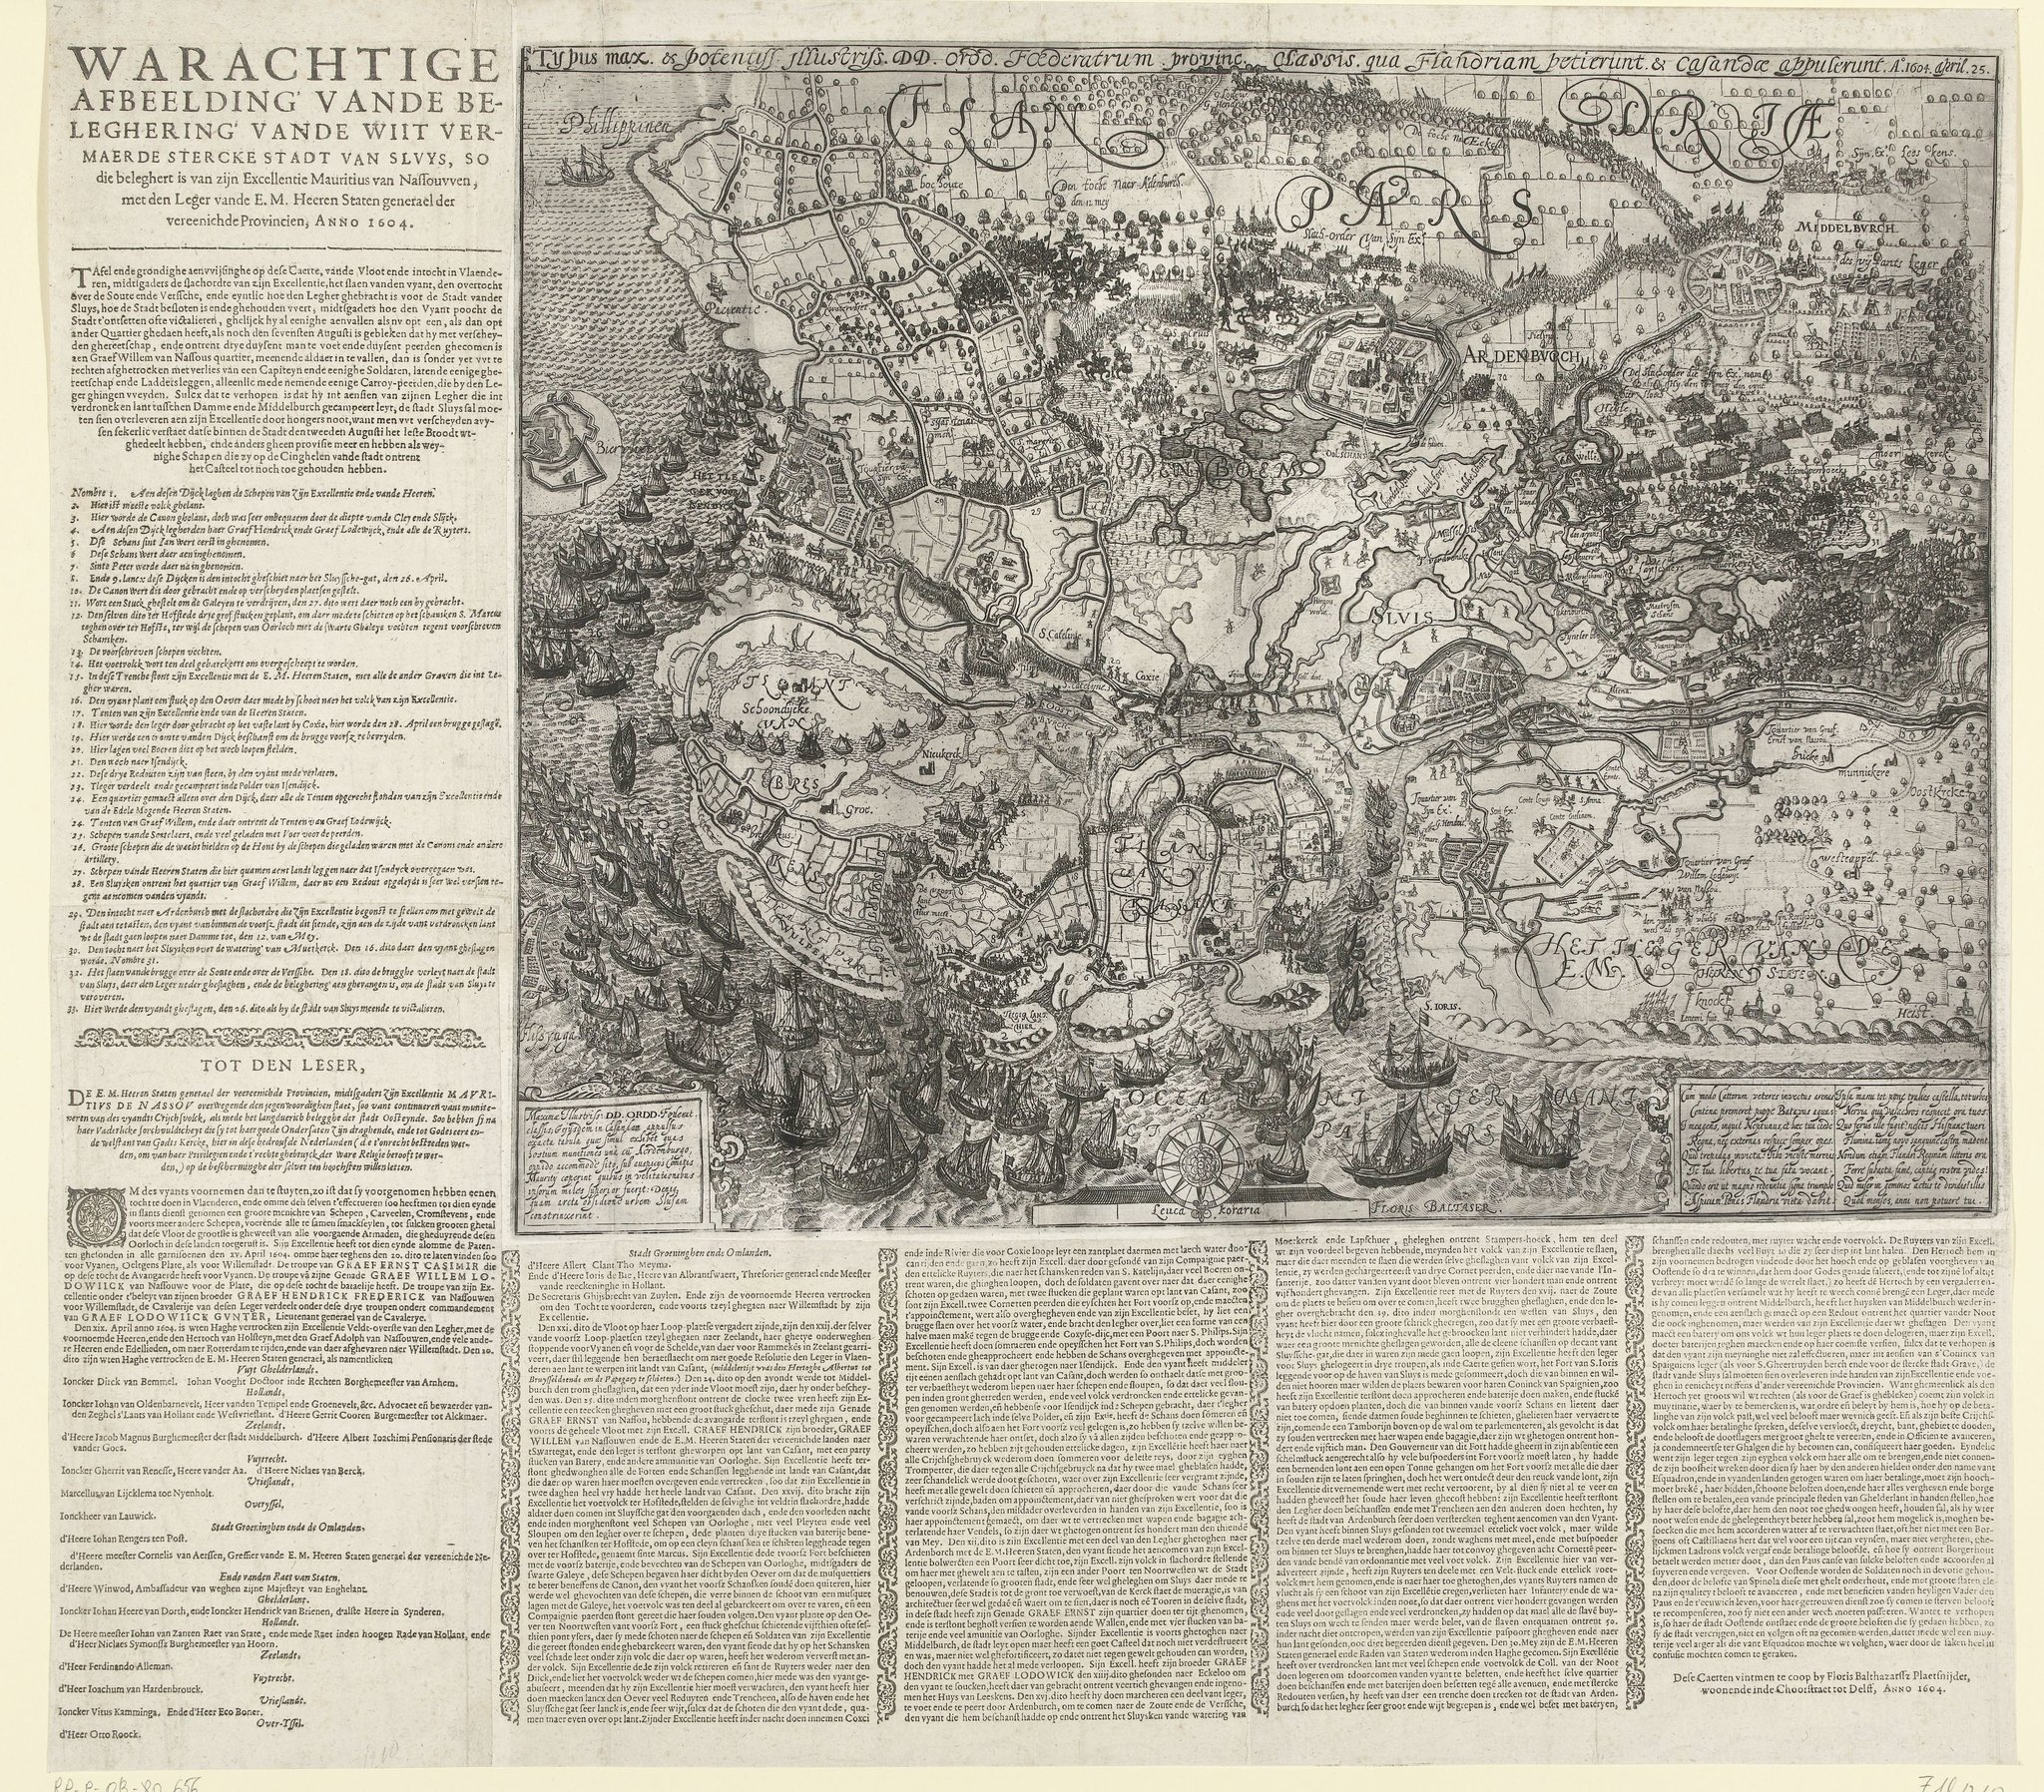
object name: map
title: Warachtige afbeelding van de beleghering van de wiit vermaerde stercke stadt van Sluys (...)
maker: floris balthasarsz. van berckenrode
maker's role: print maker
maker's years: 1562-1616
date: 1604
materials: paper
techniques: etching, letterpress printing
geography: delft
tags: maurice (prince of orange), maps of separate countries or regions, siege, position war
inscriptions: date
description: Het beleg en de inname van Sluis door het Staatse leger onder Maurits, 20 augustus 1604. Kaart van het land rondom Sluis, Aardenburg en Middelburg met de aankomst van de vloot bij Biervliet en Breskens en de tocht van de legers over land. Bovenaan een opschrift van één regel in het Latijn, rechtsonder een cartouche met een vers van 16 regels in het Latijn, links de opdracht. Links en onderaan vastplakte apart gedrukte tekstbladen met een beschrijving van de gebeurtenissen in het Nederlands.